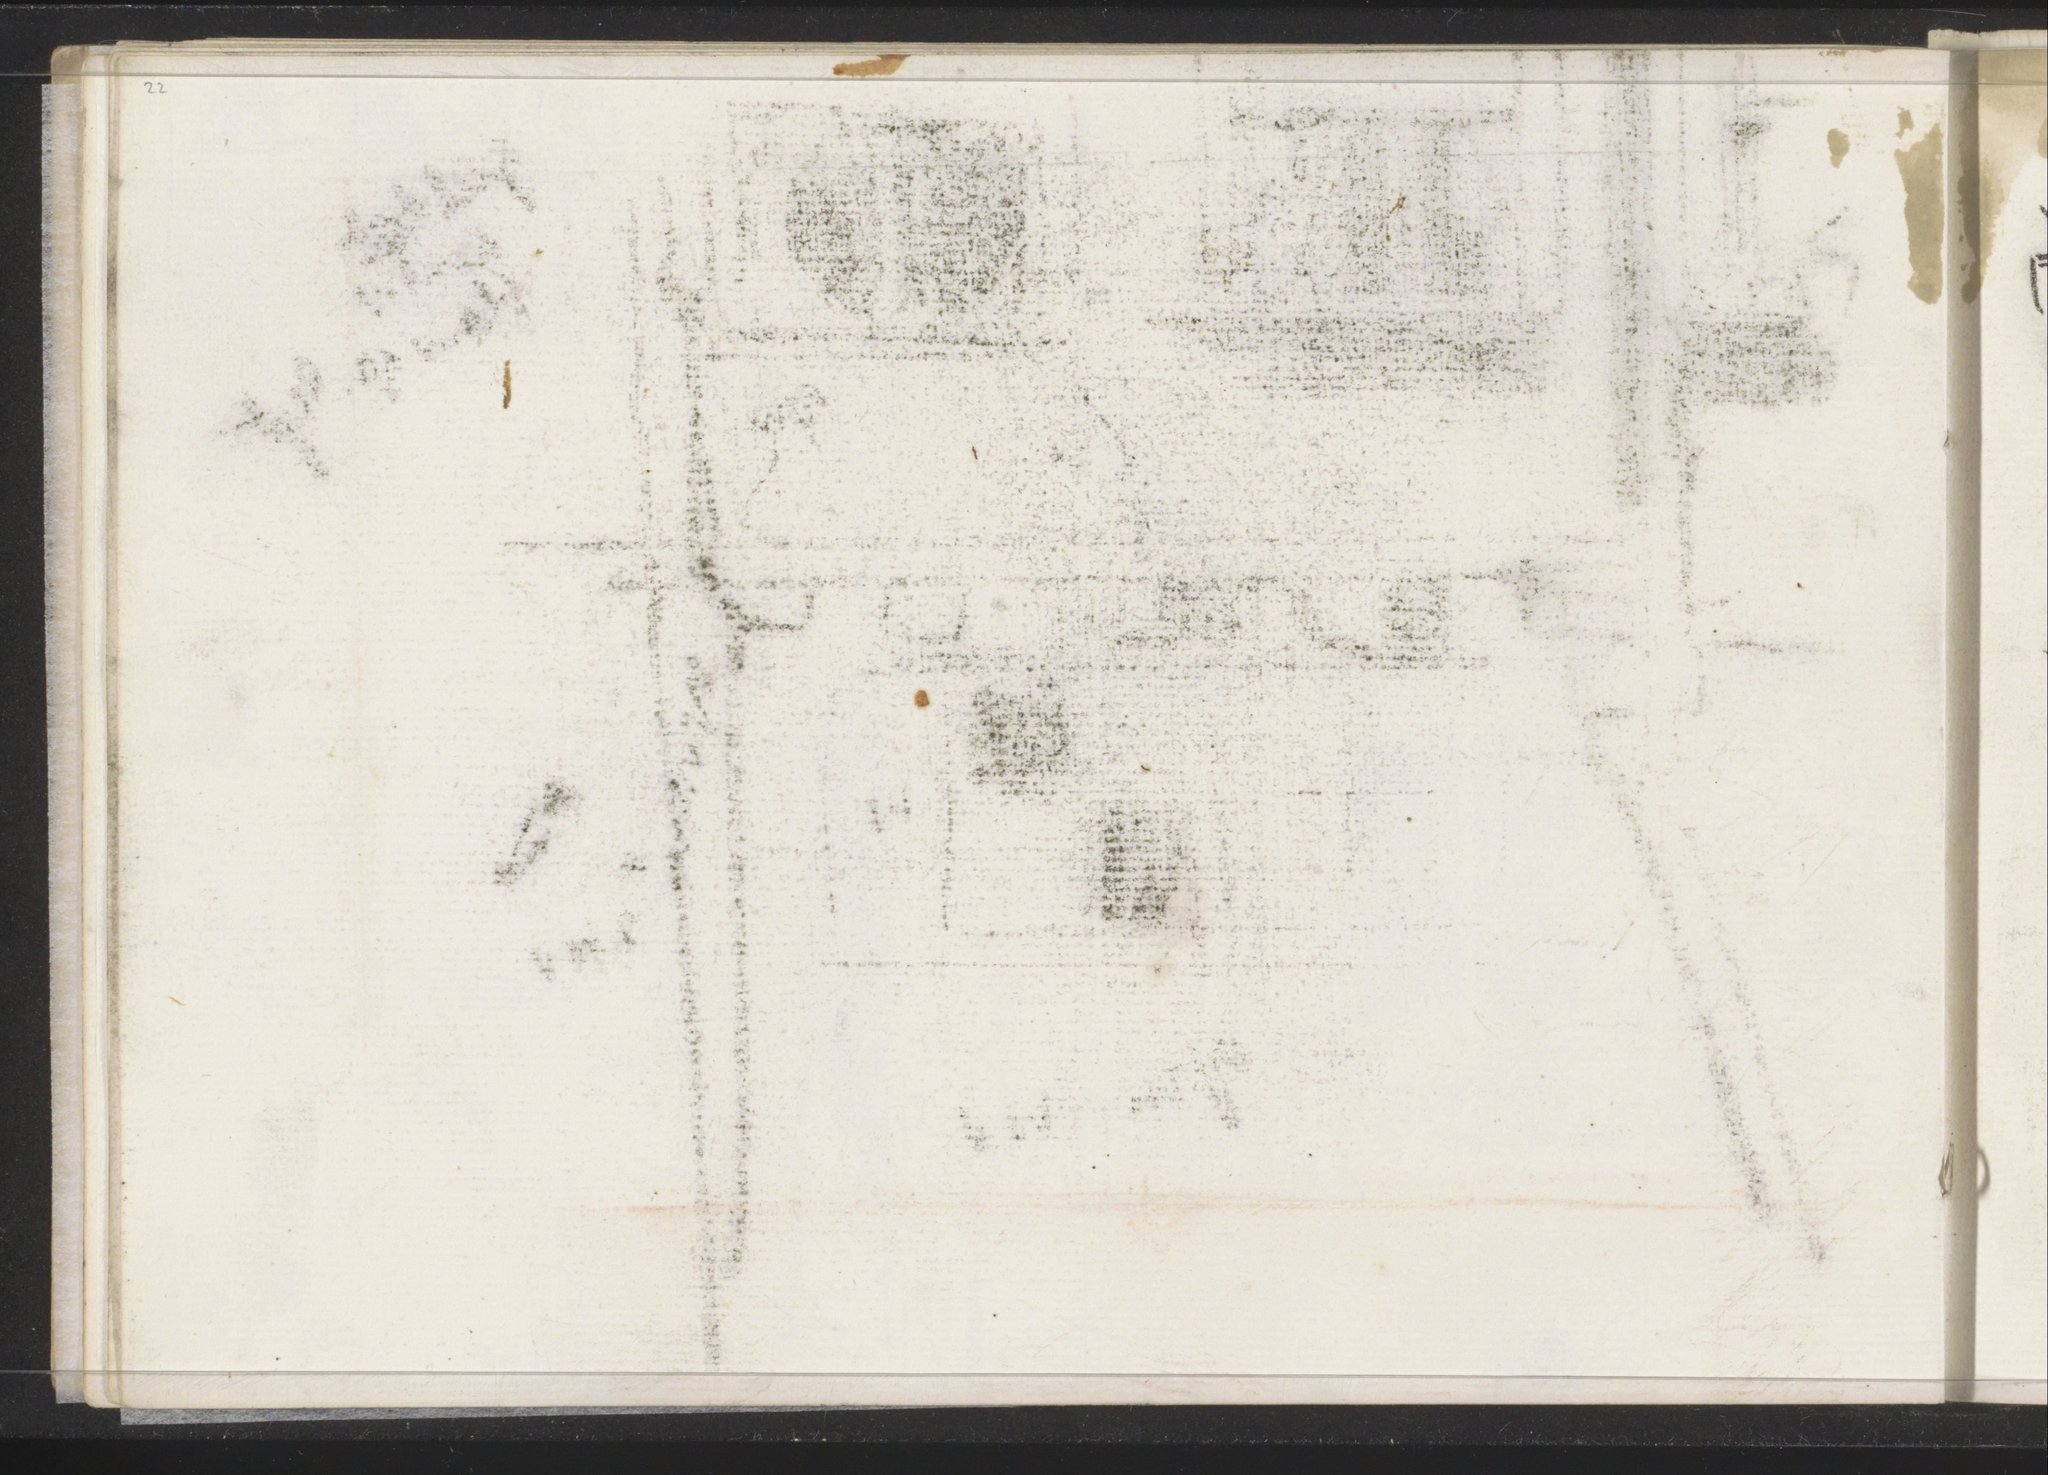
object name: sketchbook leaf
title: Abklatsch van de krijttekening op pagina 23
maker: willem witsen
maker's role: draughtsman, painter, print maker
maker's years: 1860-1923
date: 1897-1899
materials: paper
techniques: printmaking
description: Pagina 22 uit een schetsboek met 17 bladen.